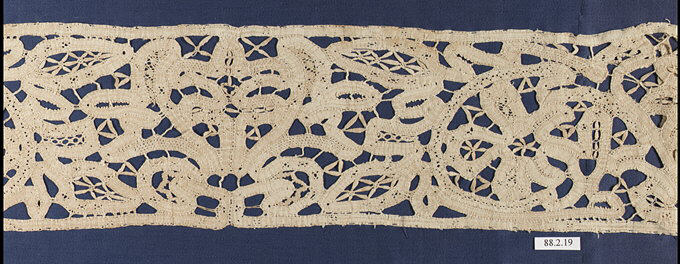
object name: strip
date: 1601-1700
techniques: lace